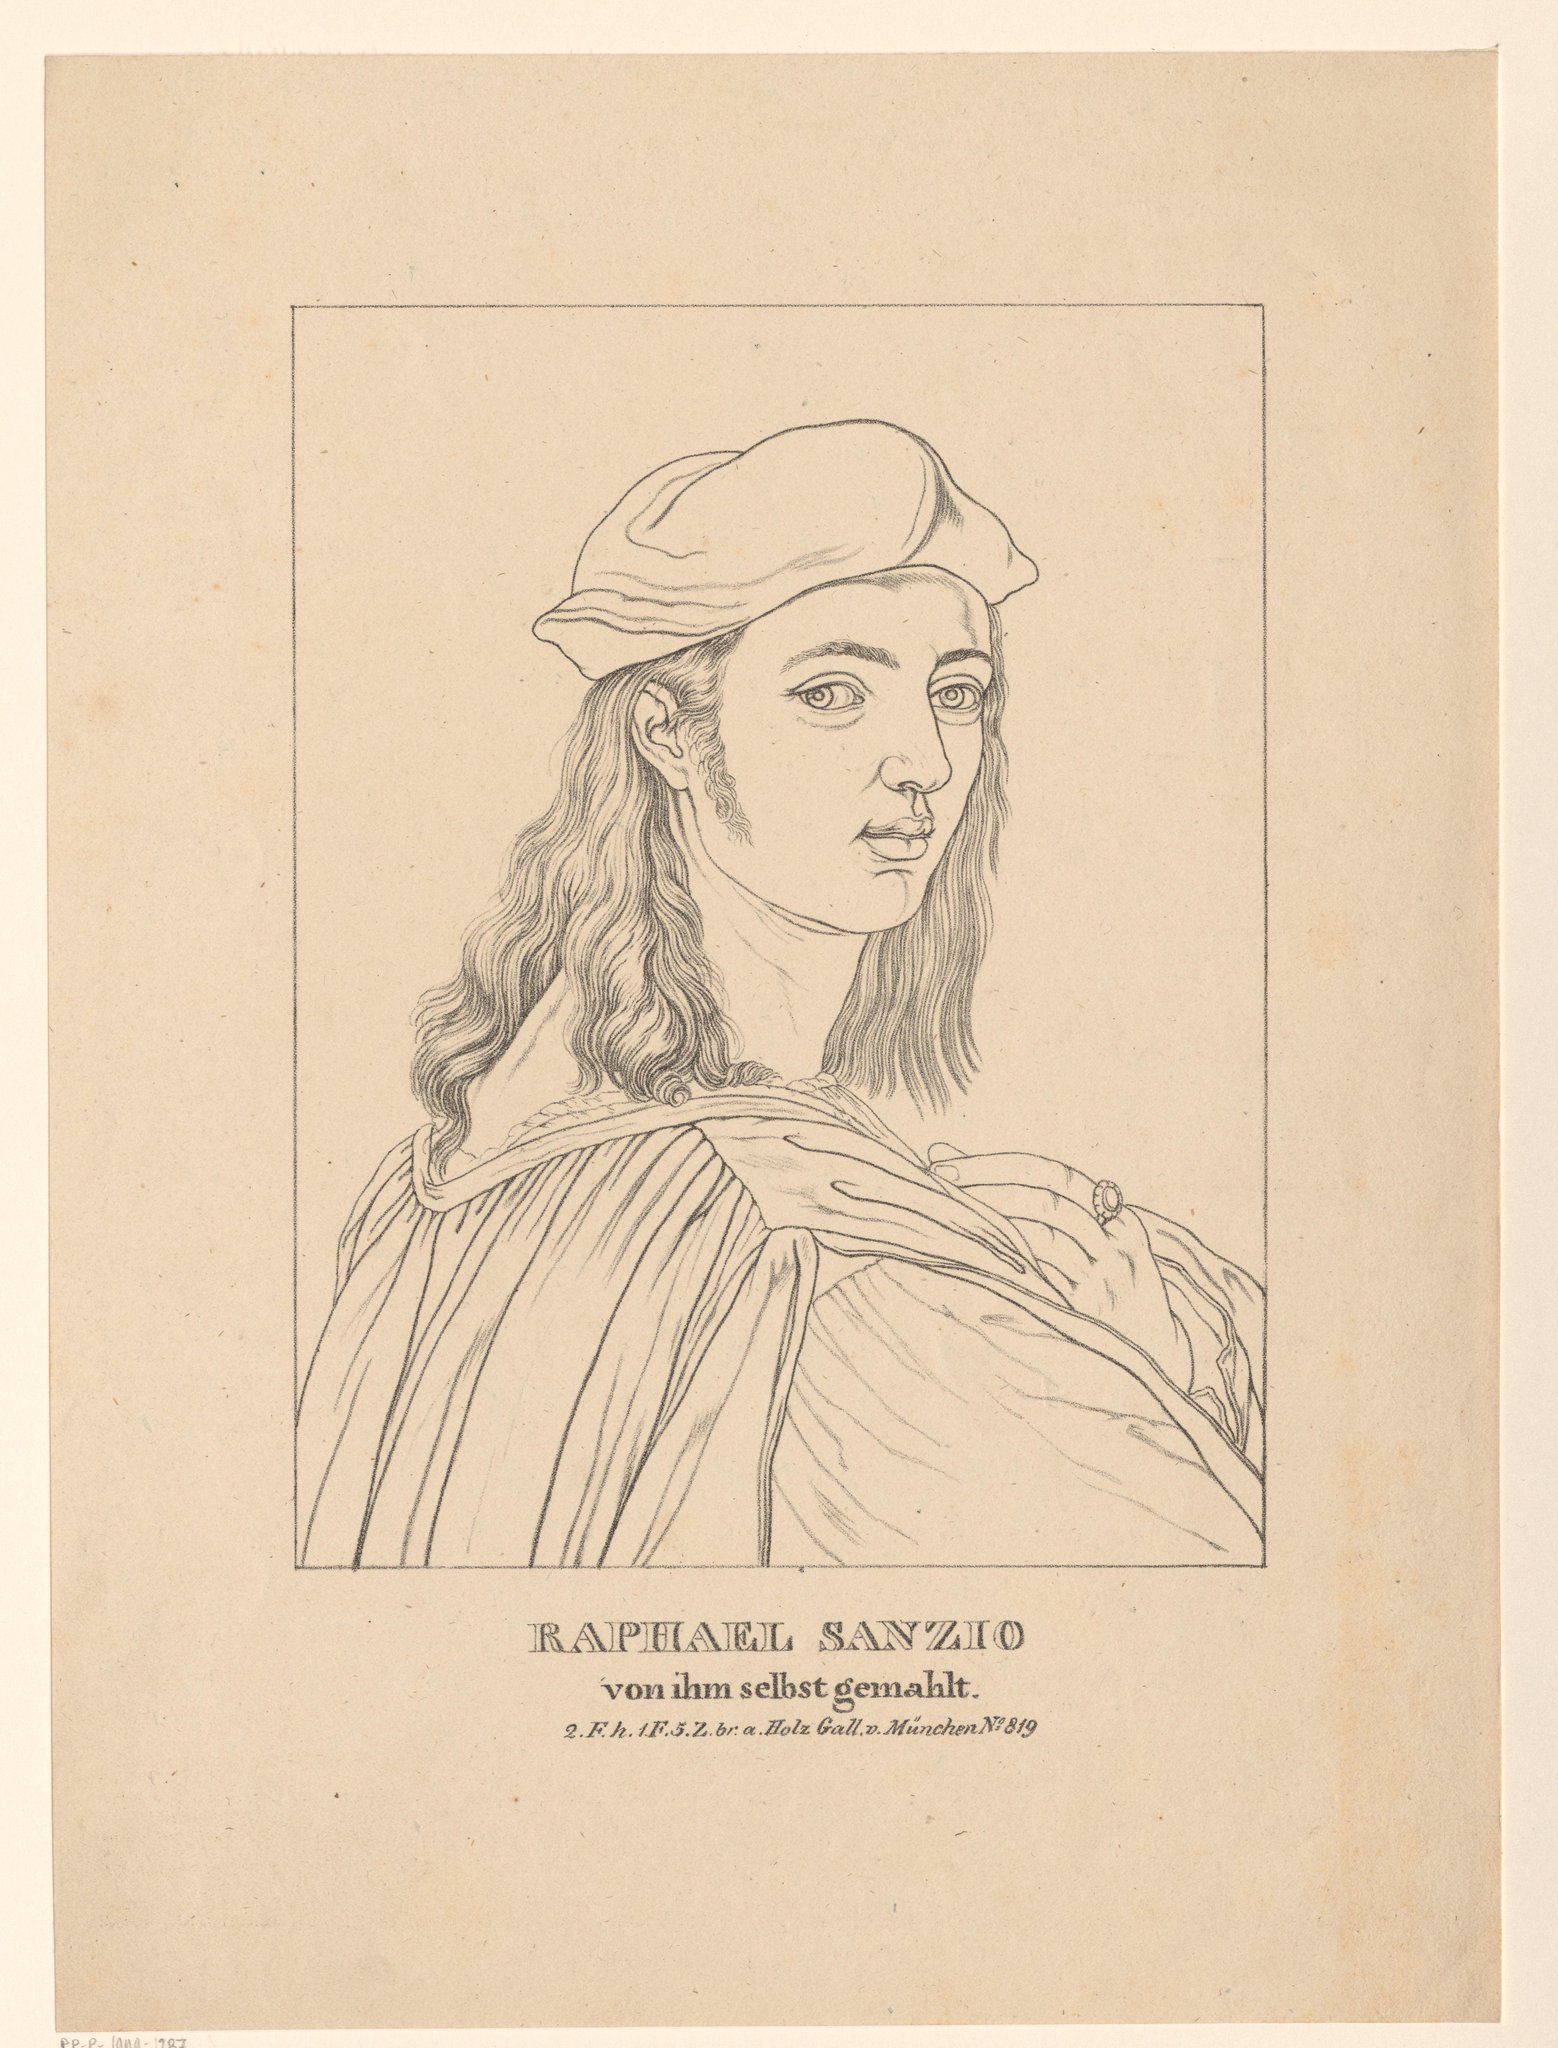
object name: print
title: Portret van Rafaël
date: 1800-1899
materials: paper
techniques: lithograph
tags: rome, painter, rafaël, historical persons, portrait, self-portrait of painter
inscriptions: collector's mark: Lugt 2228, collector's mark: Lugt 2760